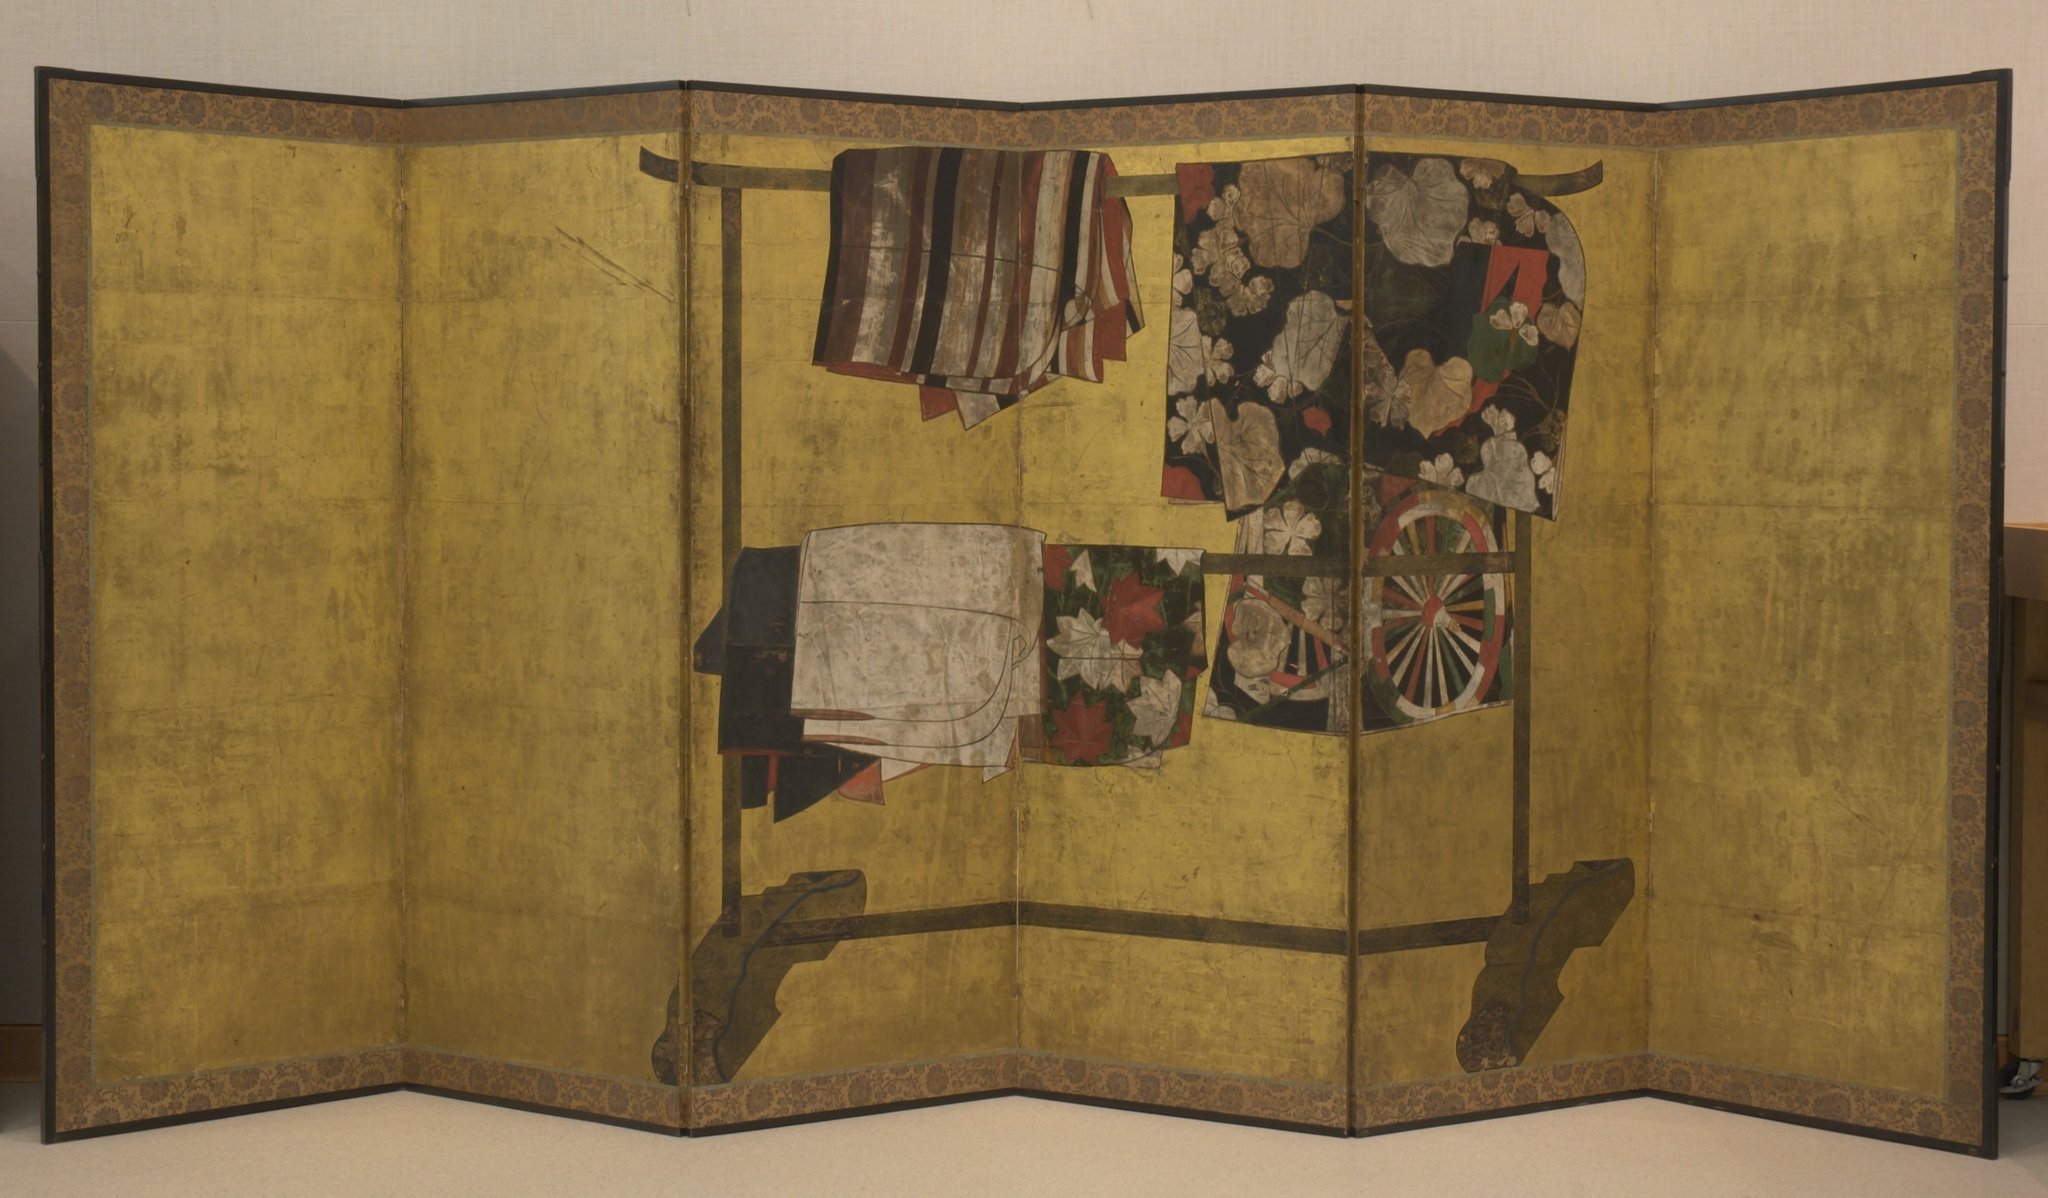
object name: screen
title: Whose Sleeves? (Tagasode)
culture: japanese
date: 1601-1700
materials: gold, ink, panel, paper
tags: robes